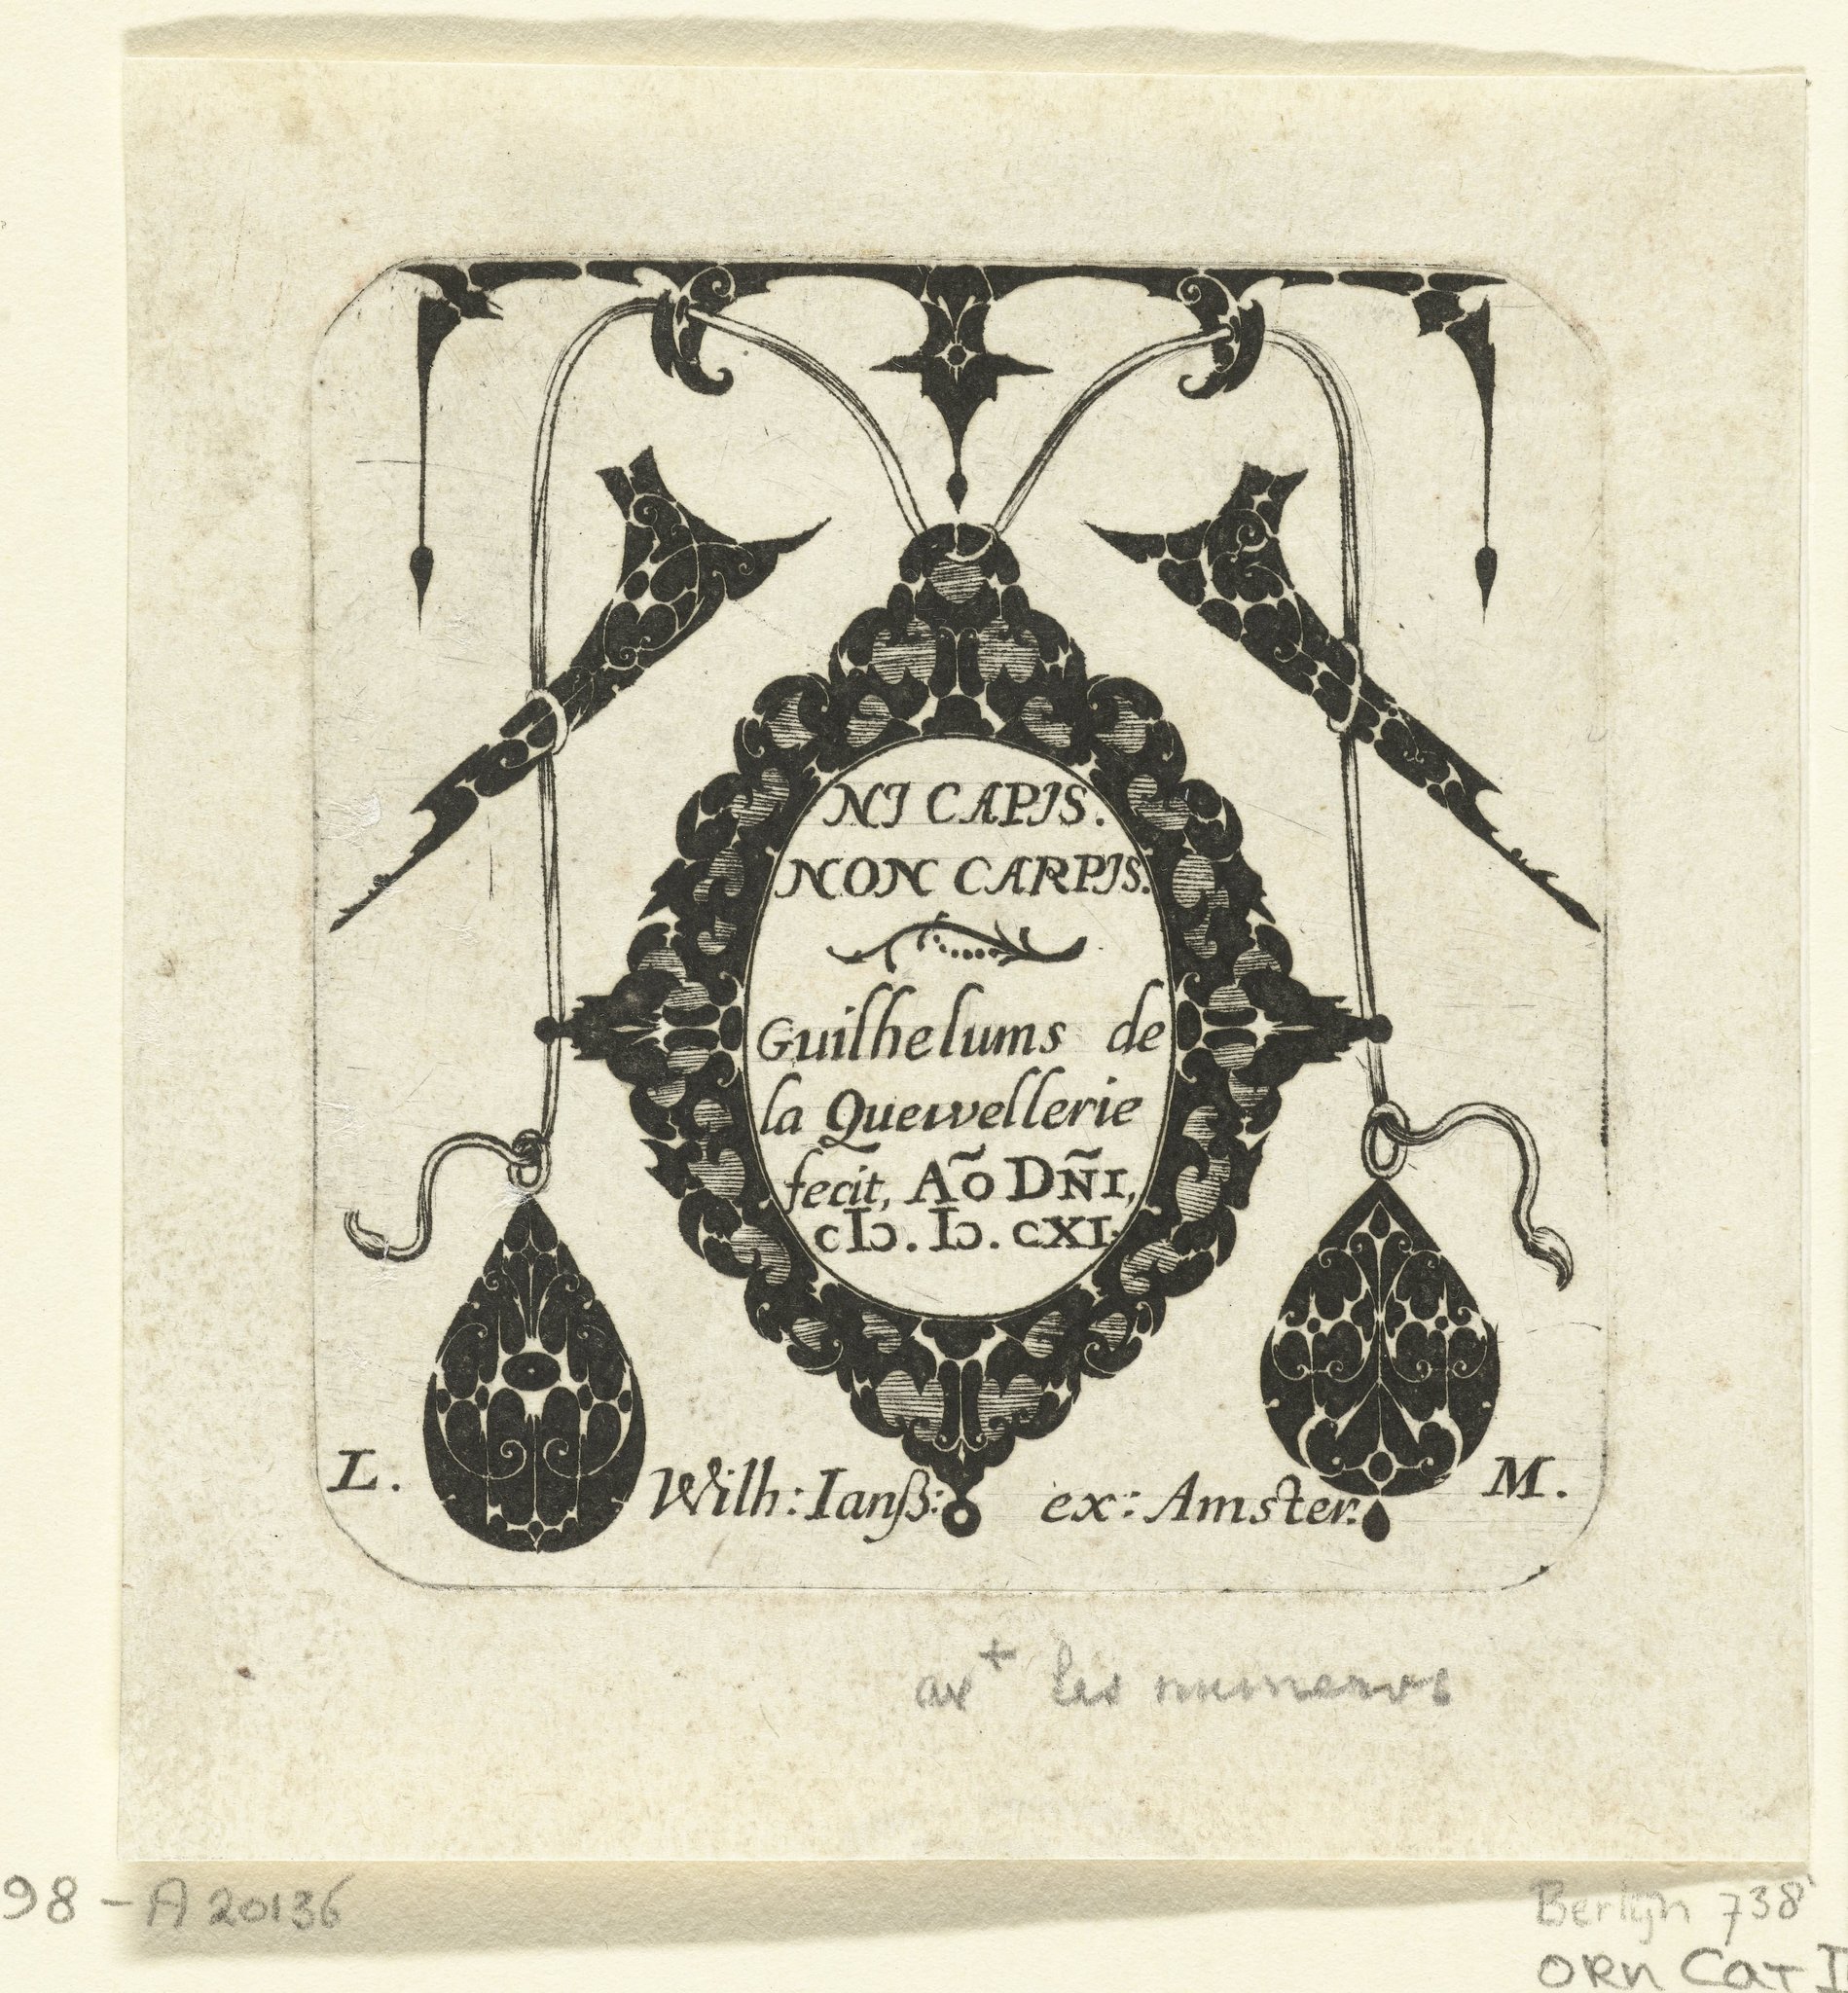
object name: print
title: Ovaal medaillon met tekst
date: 1611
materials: paper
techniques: engraving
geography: amsterdam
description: Het medaillon hangt aan een lint met aan beide kanten een oorring. Uit serie van 6 bladen.